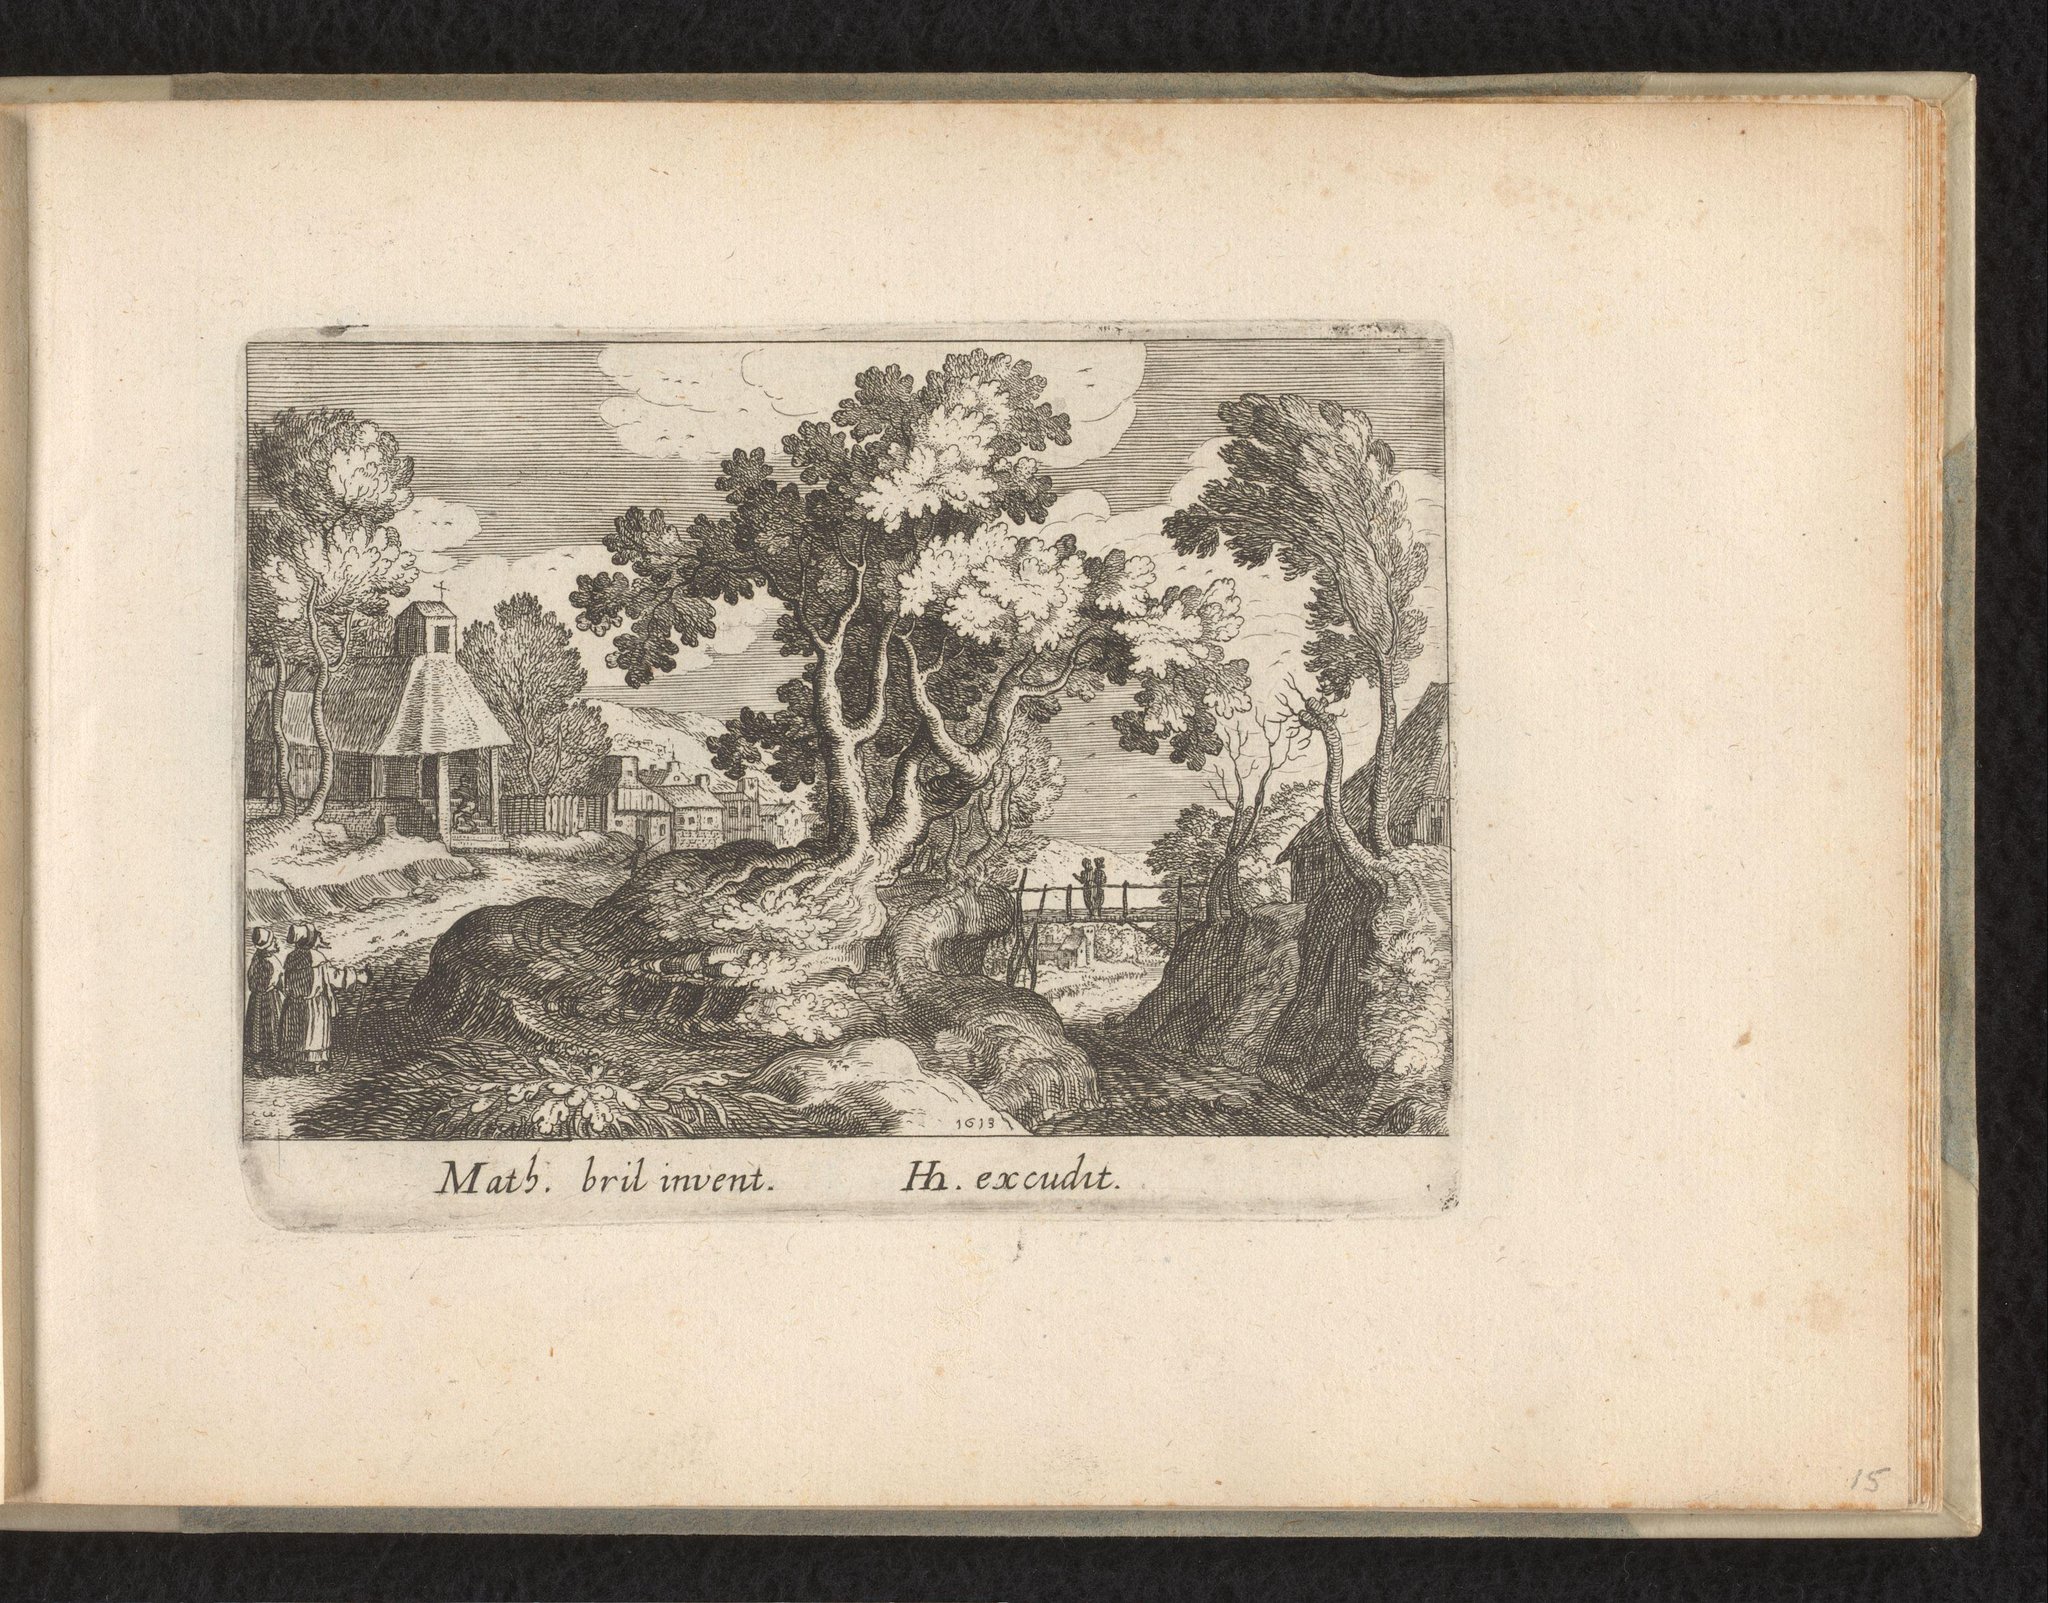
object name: print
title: Landschap met links twee wandelaars en een dorpskerk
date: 1614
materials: paper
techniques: etching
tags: village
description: Linksvoor op een landweg twee mannen, op de rug gezien. Langs het pad een kleine kerk. In het midden een bomengroep. Rechts een stroompje waarover en houten brug met twee figuurtjes.